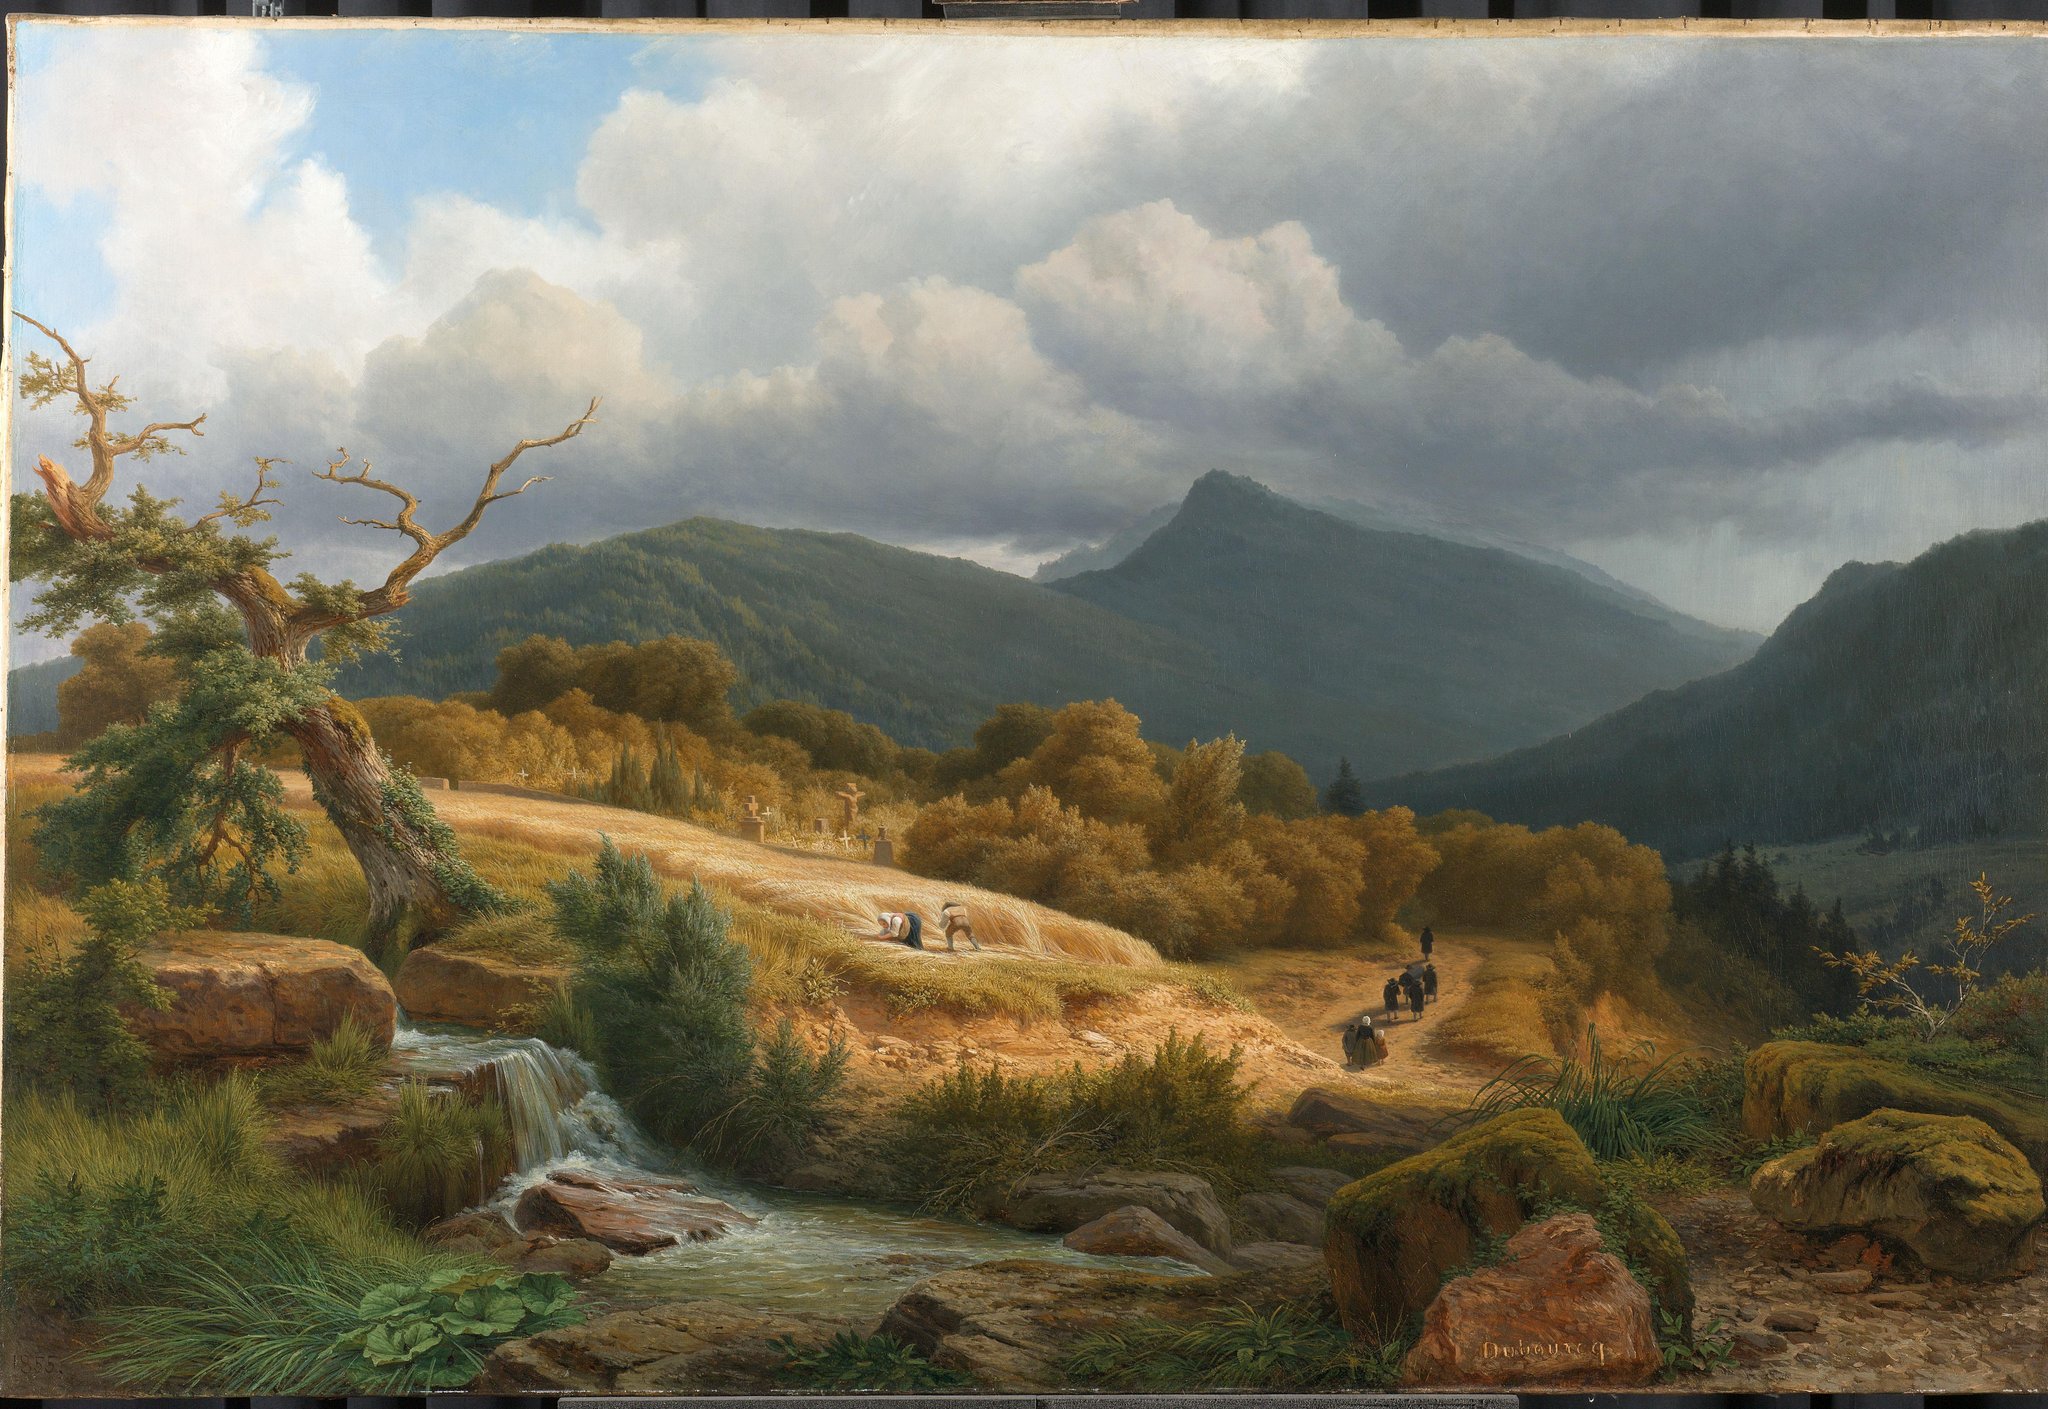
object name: painting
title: The Cemetery at Baden-Baden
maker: pierre louis dubourcq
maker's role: draughtsman, painter, print maker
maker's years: 1815-1873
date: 1855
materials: canvas, oil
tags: (high) hill, churchyard, cemetery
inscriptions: signature and date: ‘Dubourcq 1855’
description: De begraafplaats te Baden-Baden. Berglandschap met een kleine begrafenisstoet op weg naar de begraafplaats links tussen de bomen. Op de voorgrond een watervalletje.